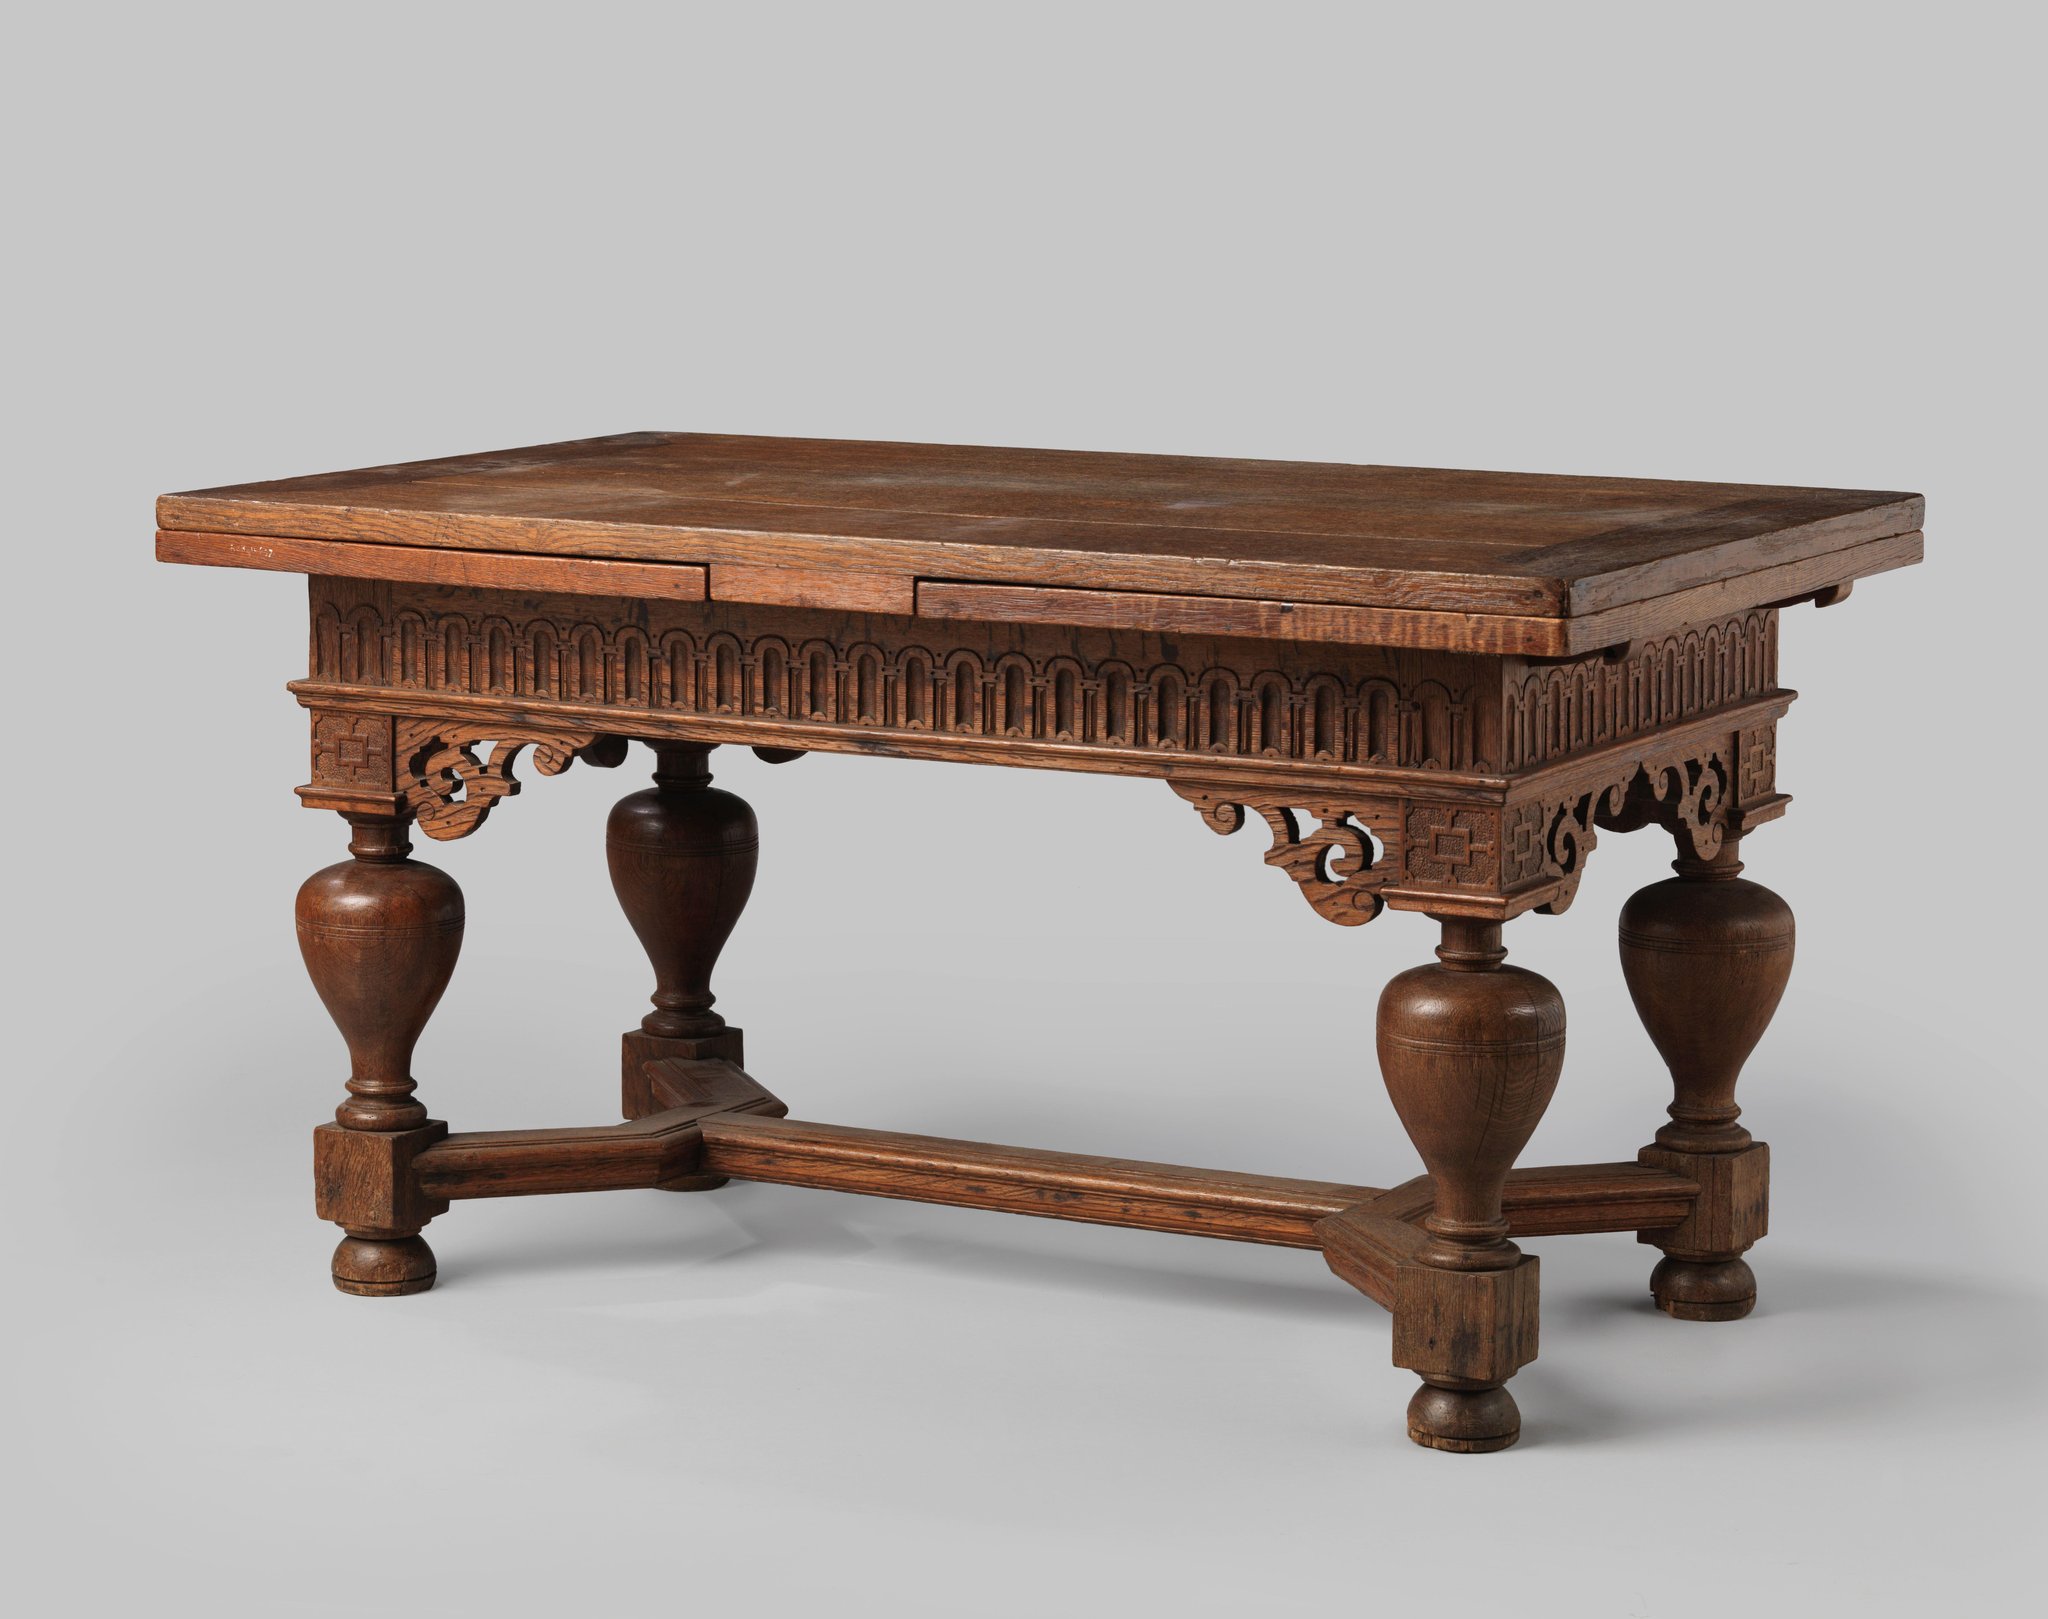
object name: table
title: Tafel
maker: Anonymous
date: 1600-1650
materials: wood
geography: netherlands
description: Tafel van eikenhout op vier door een dubbel Y-vormig kruis verbonden poten, die vaasvormig geleed zijn. Het kruis heeft uitgrondingen. De onderste huizen zijn onbewerkt, de bovenste dragen een kettingornament. De uitgezaagde steunstukken vertonen C-voluten. De regels zijn versierd met schalmen. Het meubel heeft twee trekbladen.